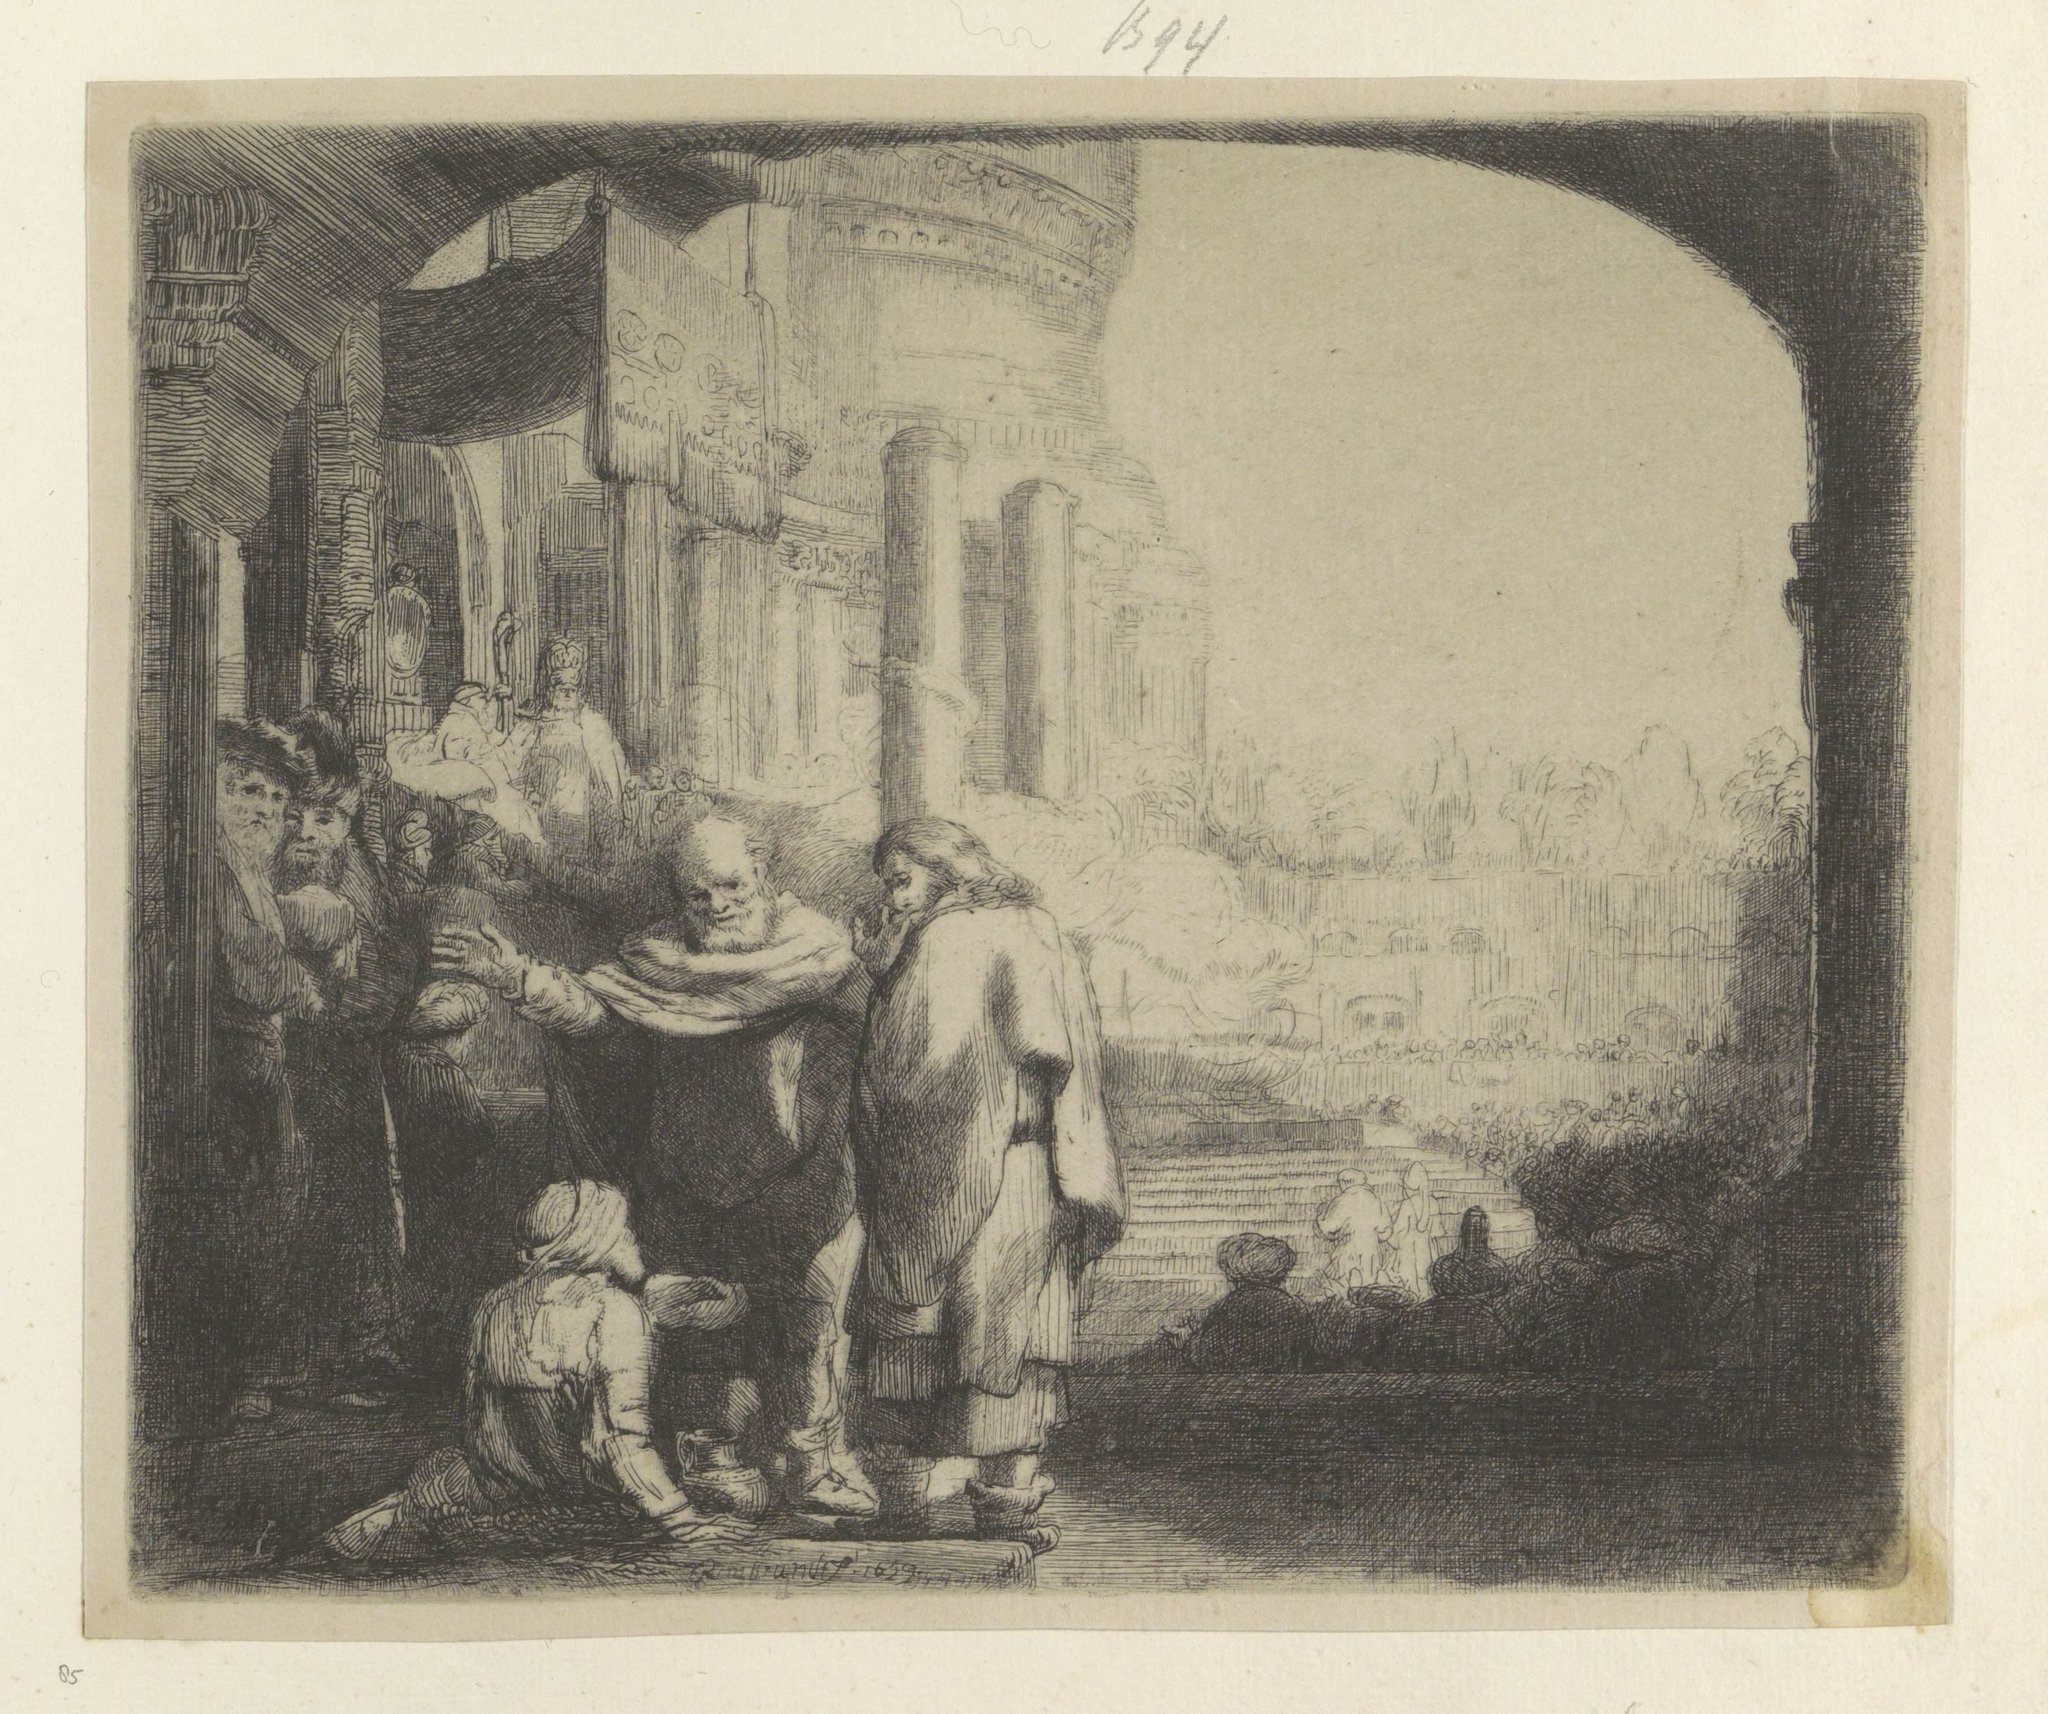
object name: print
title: Petrus en Johannes genezen een kreupele aan de Tempelpoort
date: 1659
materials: paper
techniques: drypoint, etching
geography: paris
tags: healing of a lame beggar at the beautiful gate of the temple by peter and john (acts 3 - 4:31), disabilities, deformations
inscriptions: date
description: De voorstelling is gebaseerd op de tekst uit Handelingen 3:4-31. De prent maakt deel uit van een album.